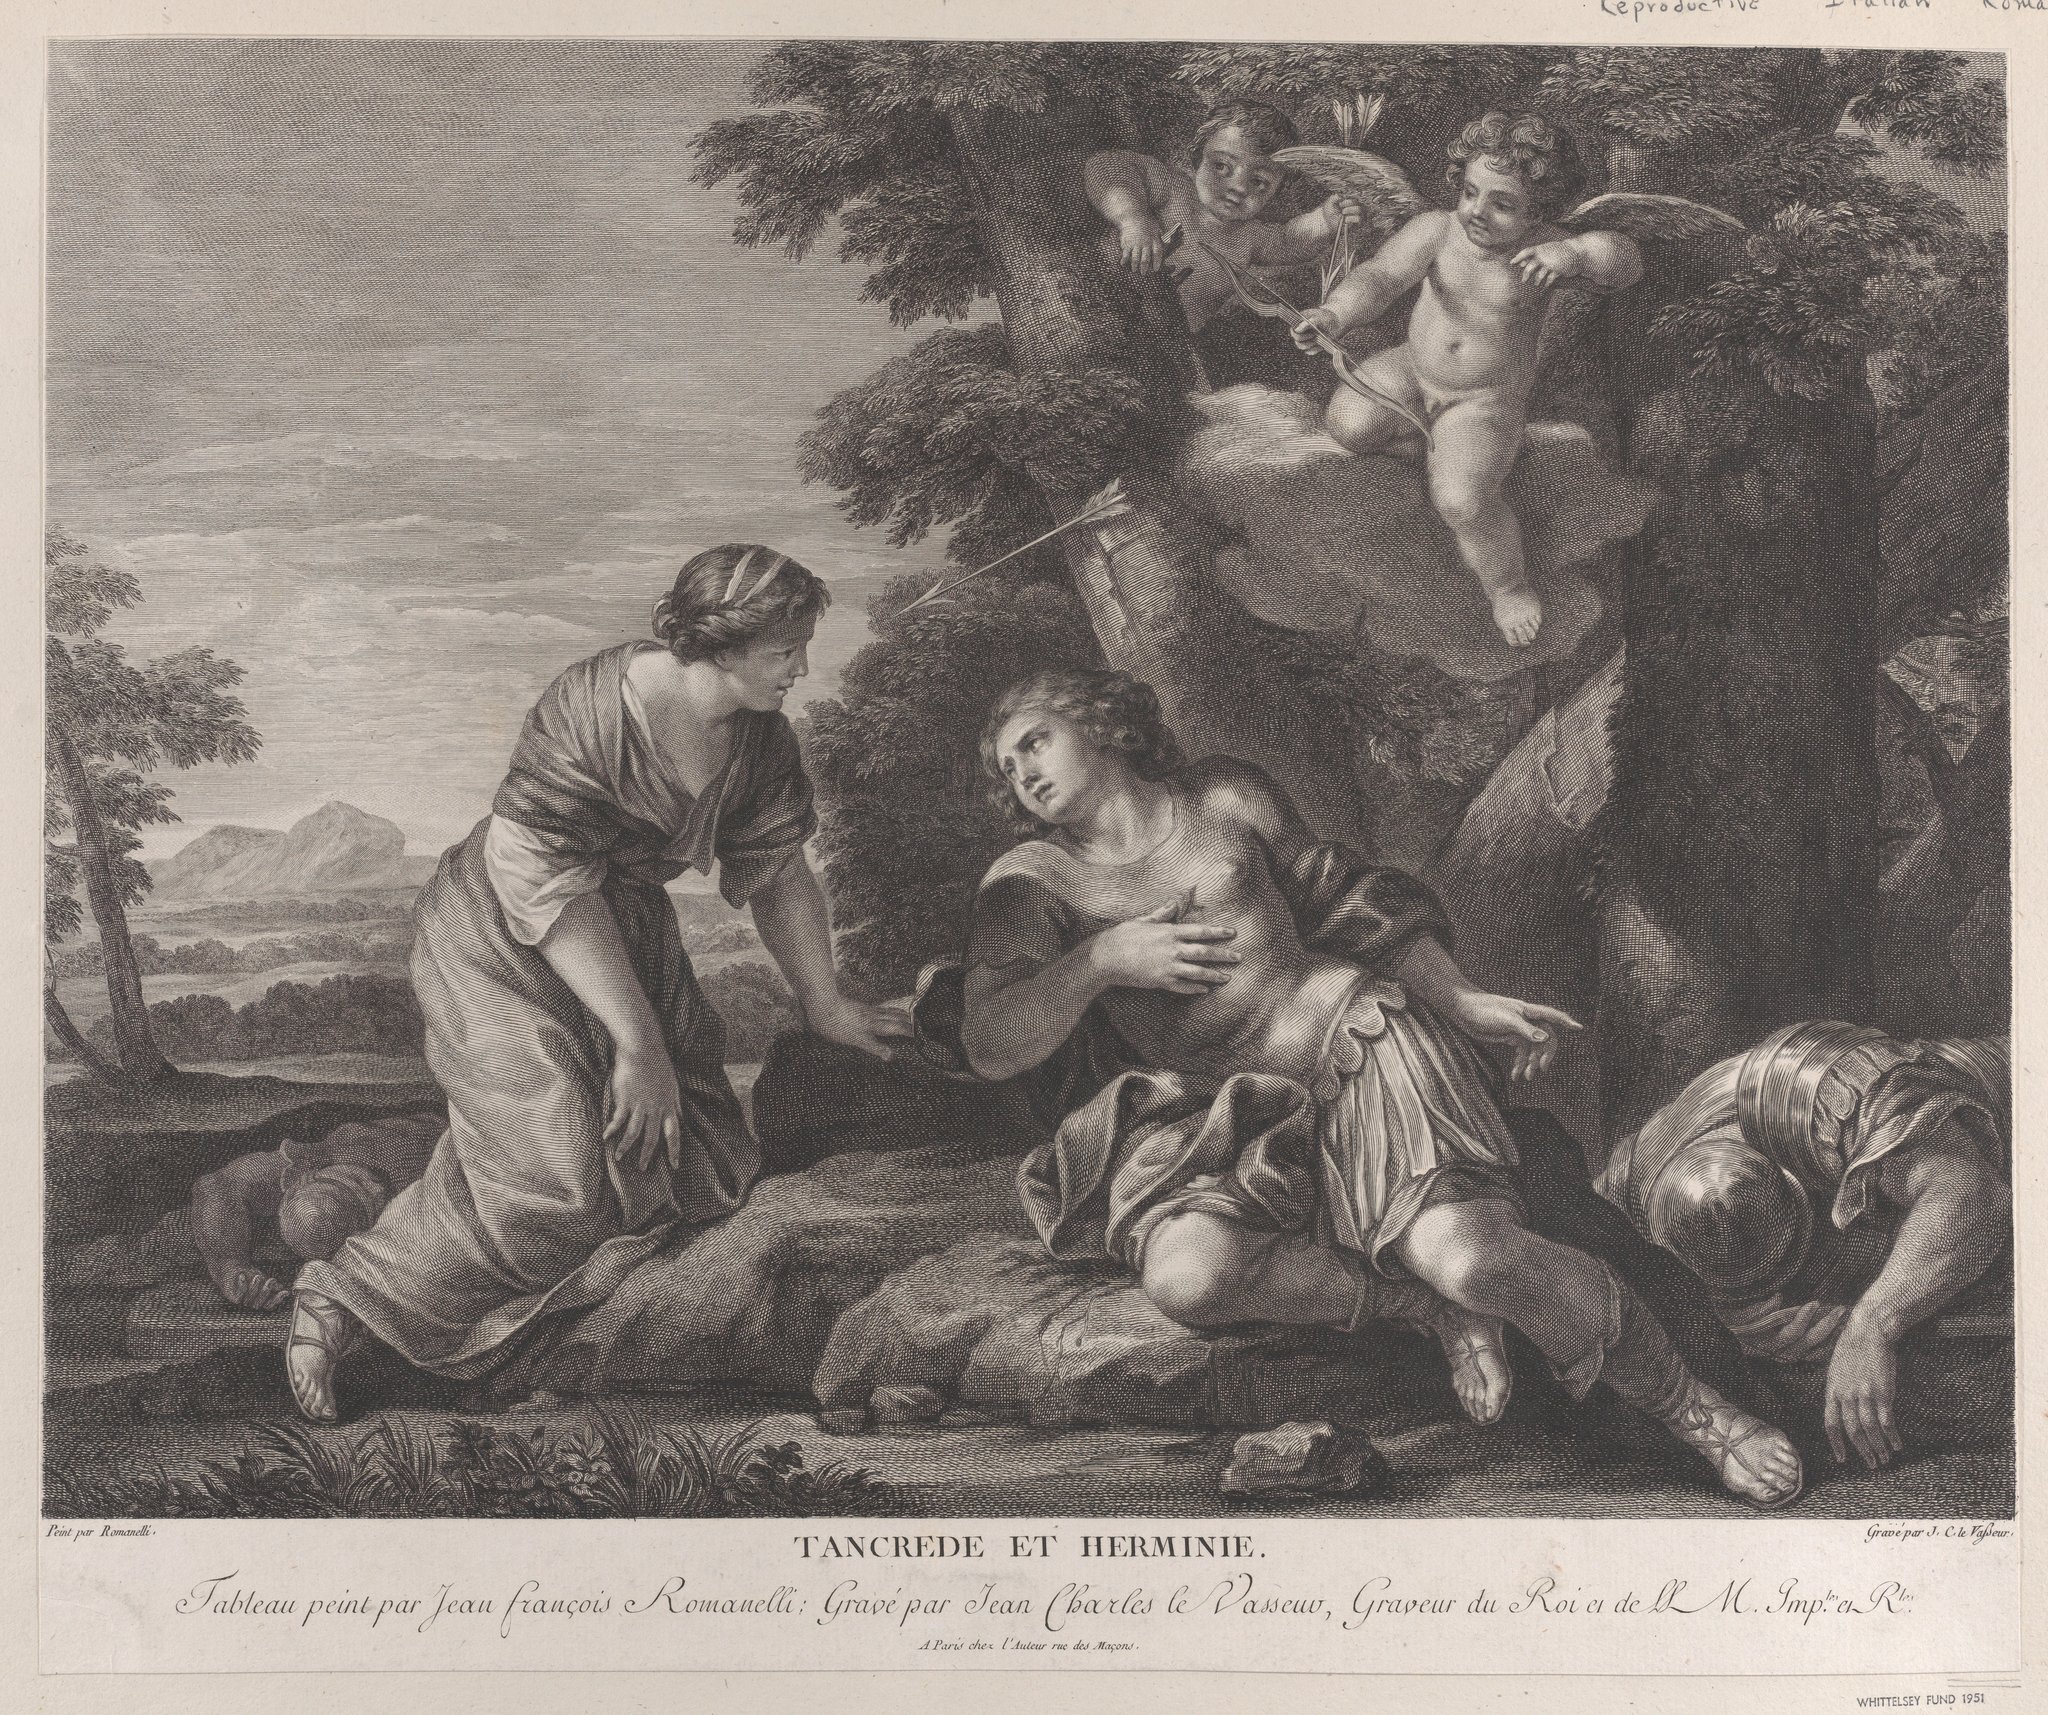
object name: print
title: Tancrede and Herminia, within a landscape, as Cupid shoots an arrow towards Herminia at upper right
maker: jean charles le vasseur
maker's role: artist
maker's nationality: french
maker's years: 1734-1816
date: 1690-1725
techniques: engraving, etching